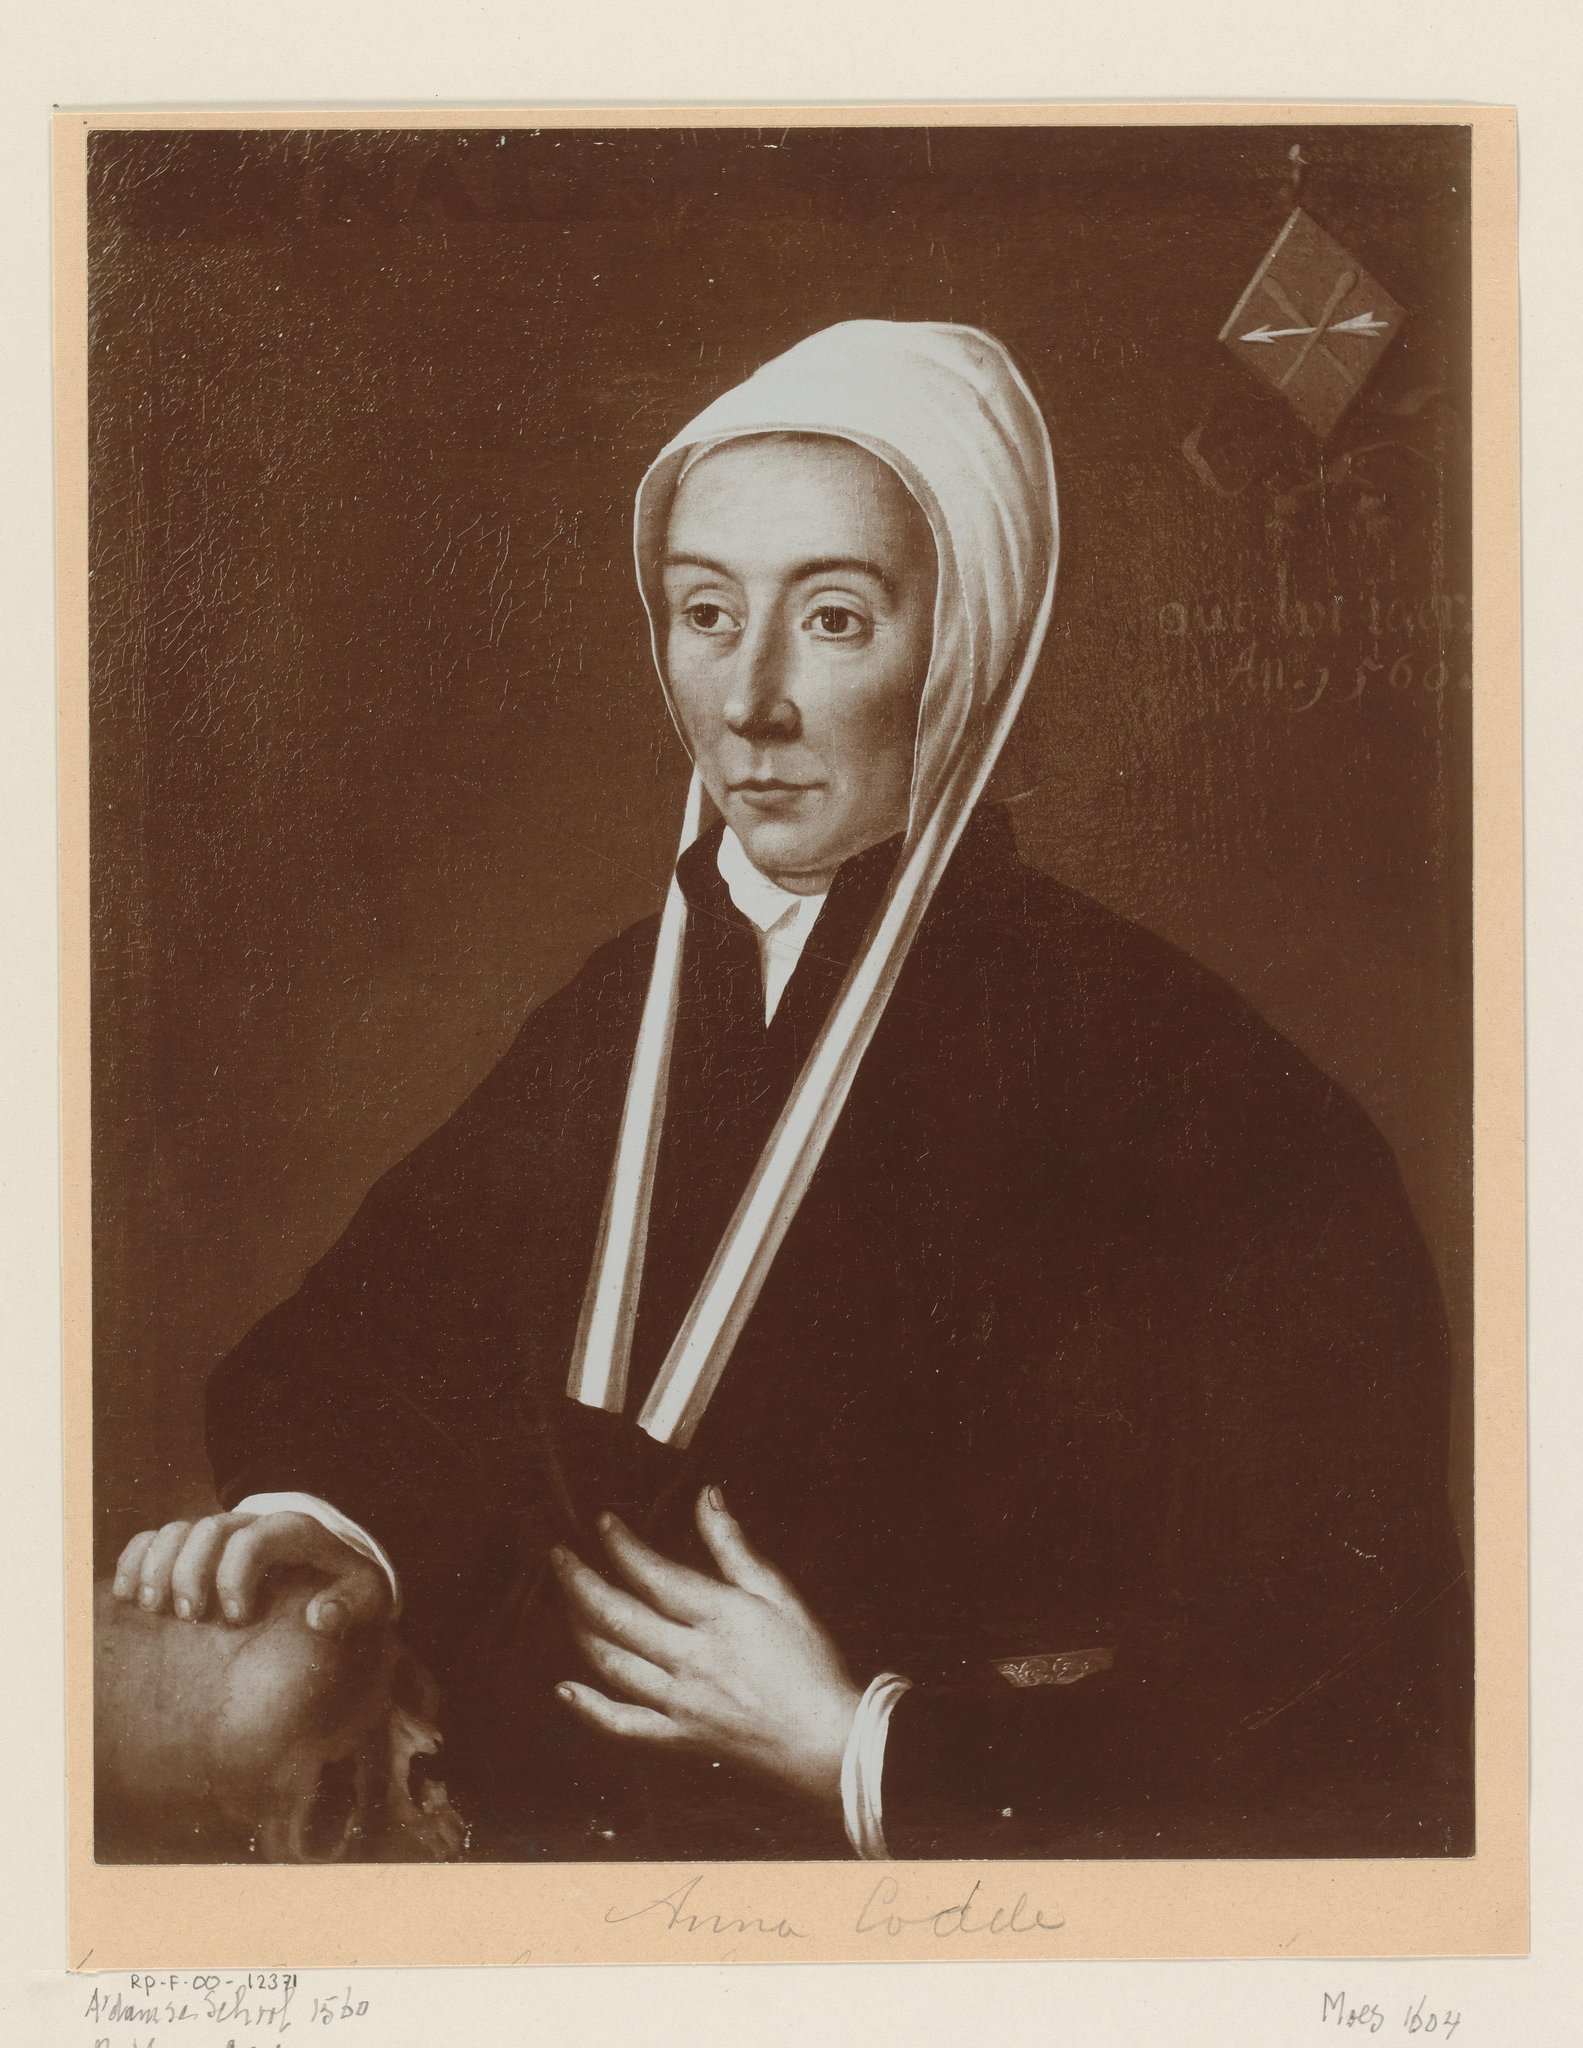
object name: reproduction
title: Fotoreproductie van een geschilderd portret van Anna Codde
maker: Anonymous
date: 1885-1910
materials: paper, cardboard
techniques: collodion silver print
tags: historical persons - bb - woman, picture, painting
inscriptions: inscription: ‘Anna Codde’, collector's mark: Lugt 2228